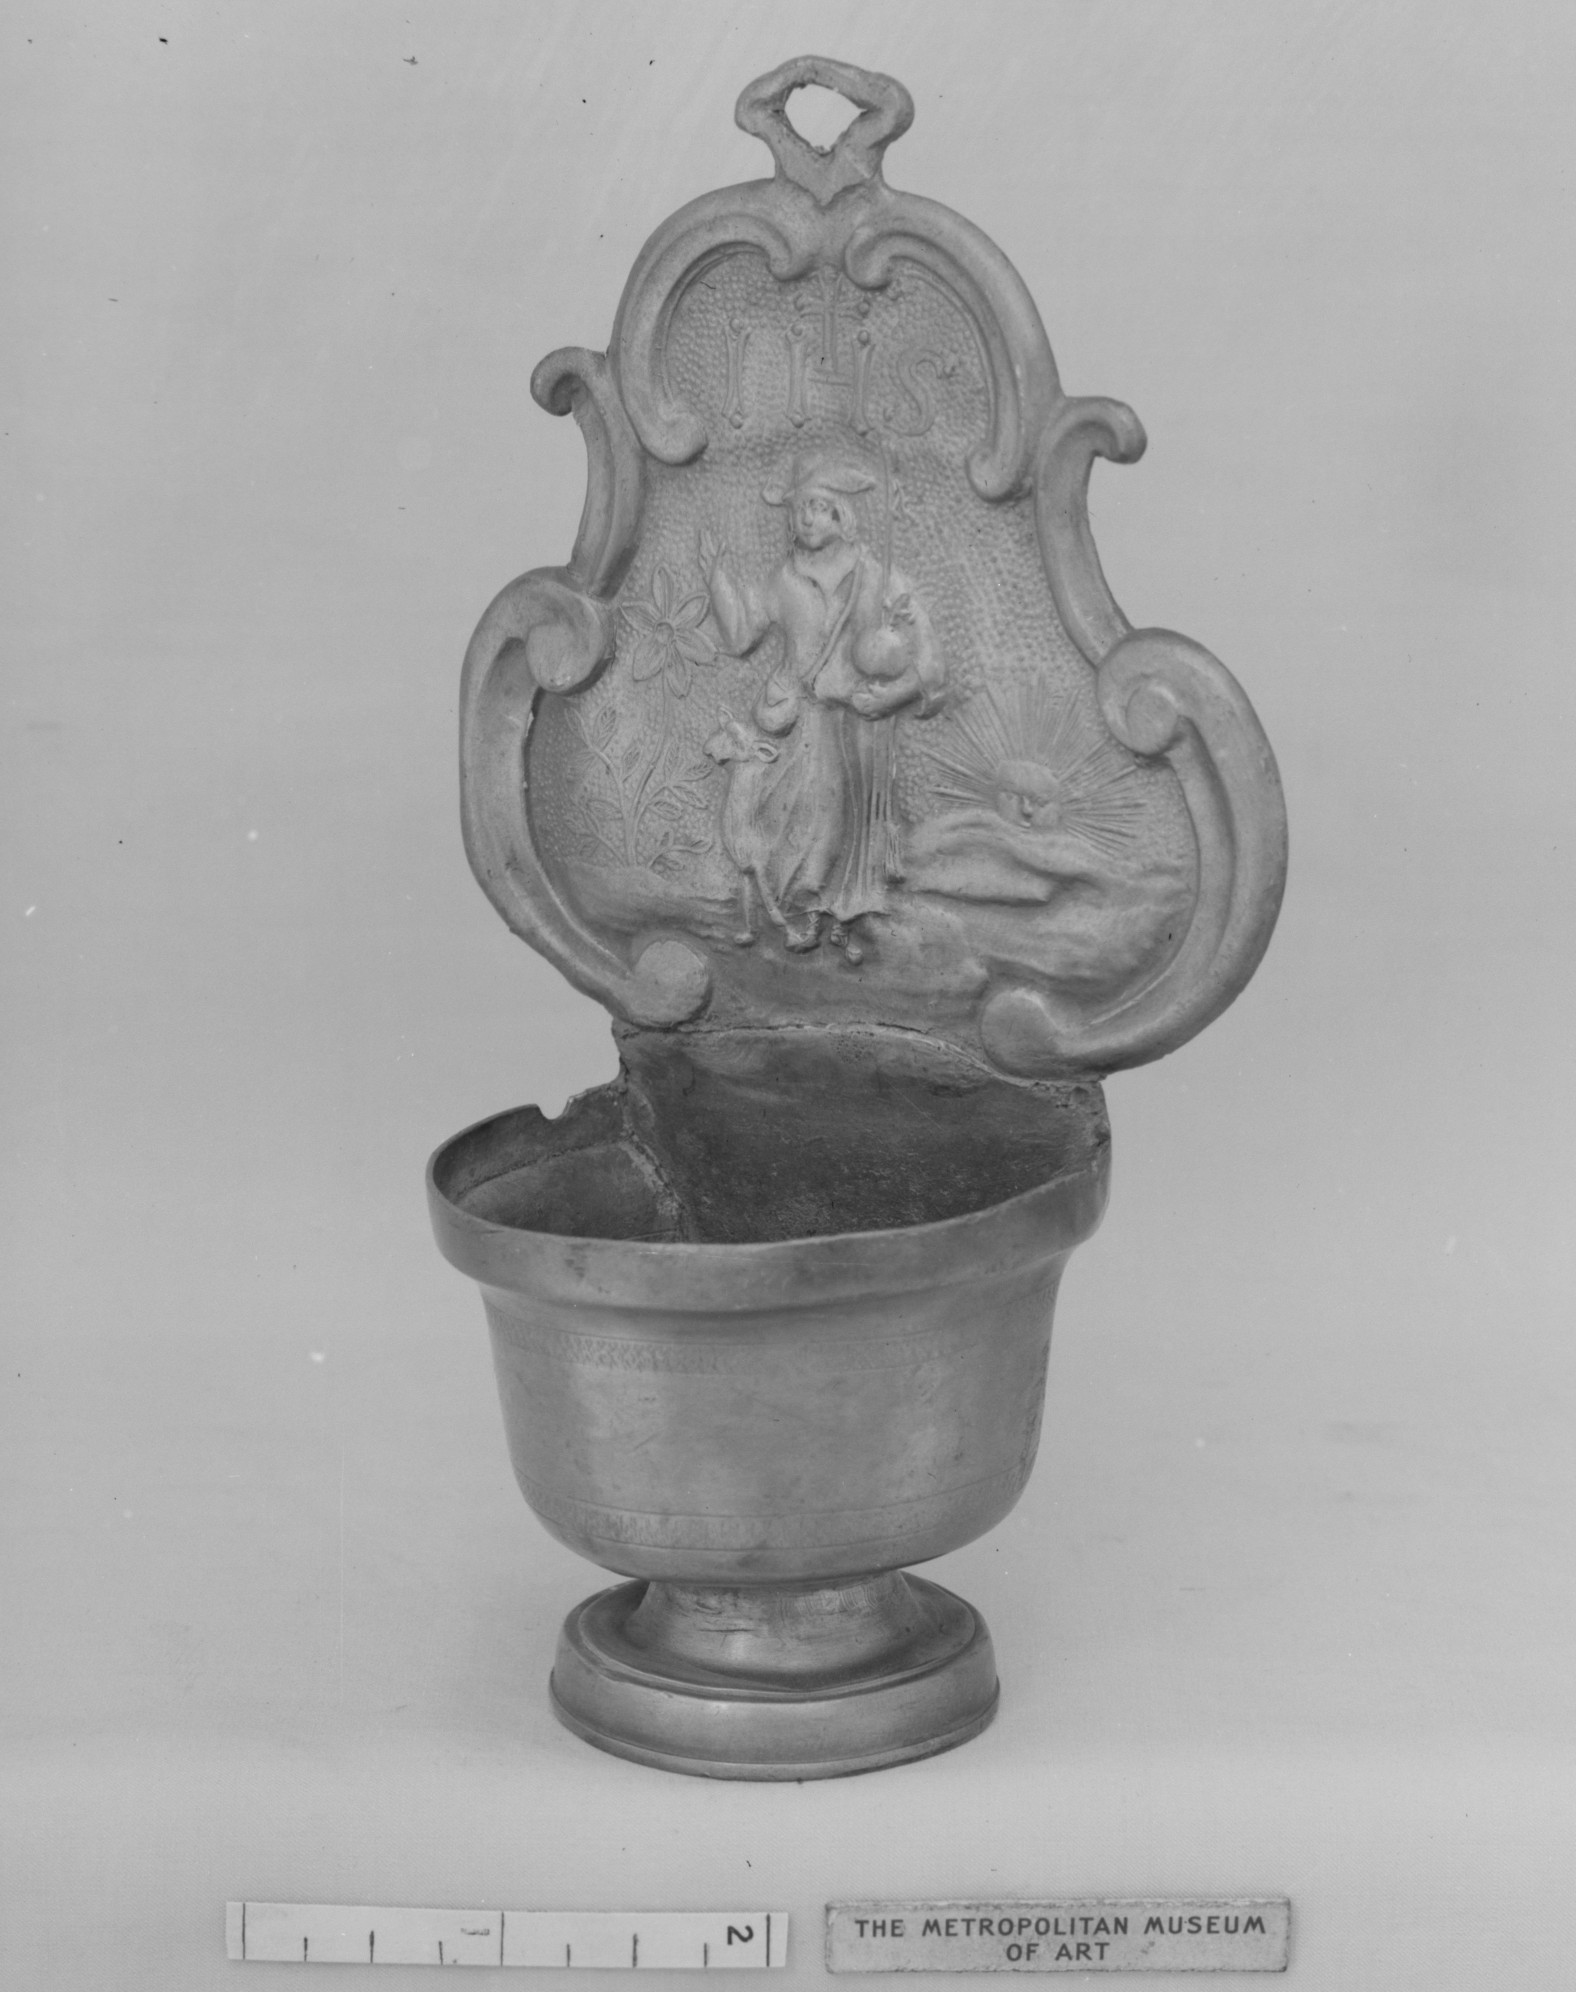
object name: bénitier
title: Standing or hanging bénitier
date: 1601-1700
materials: pewter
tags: human figures,animals